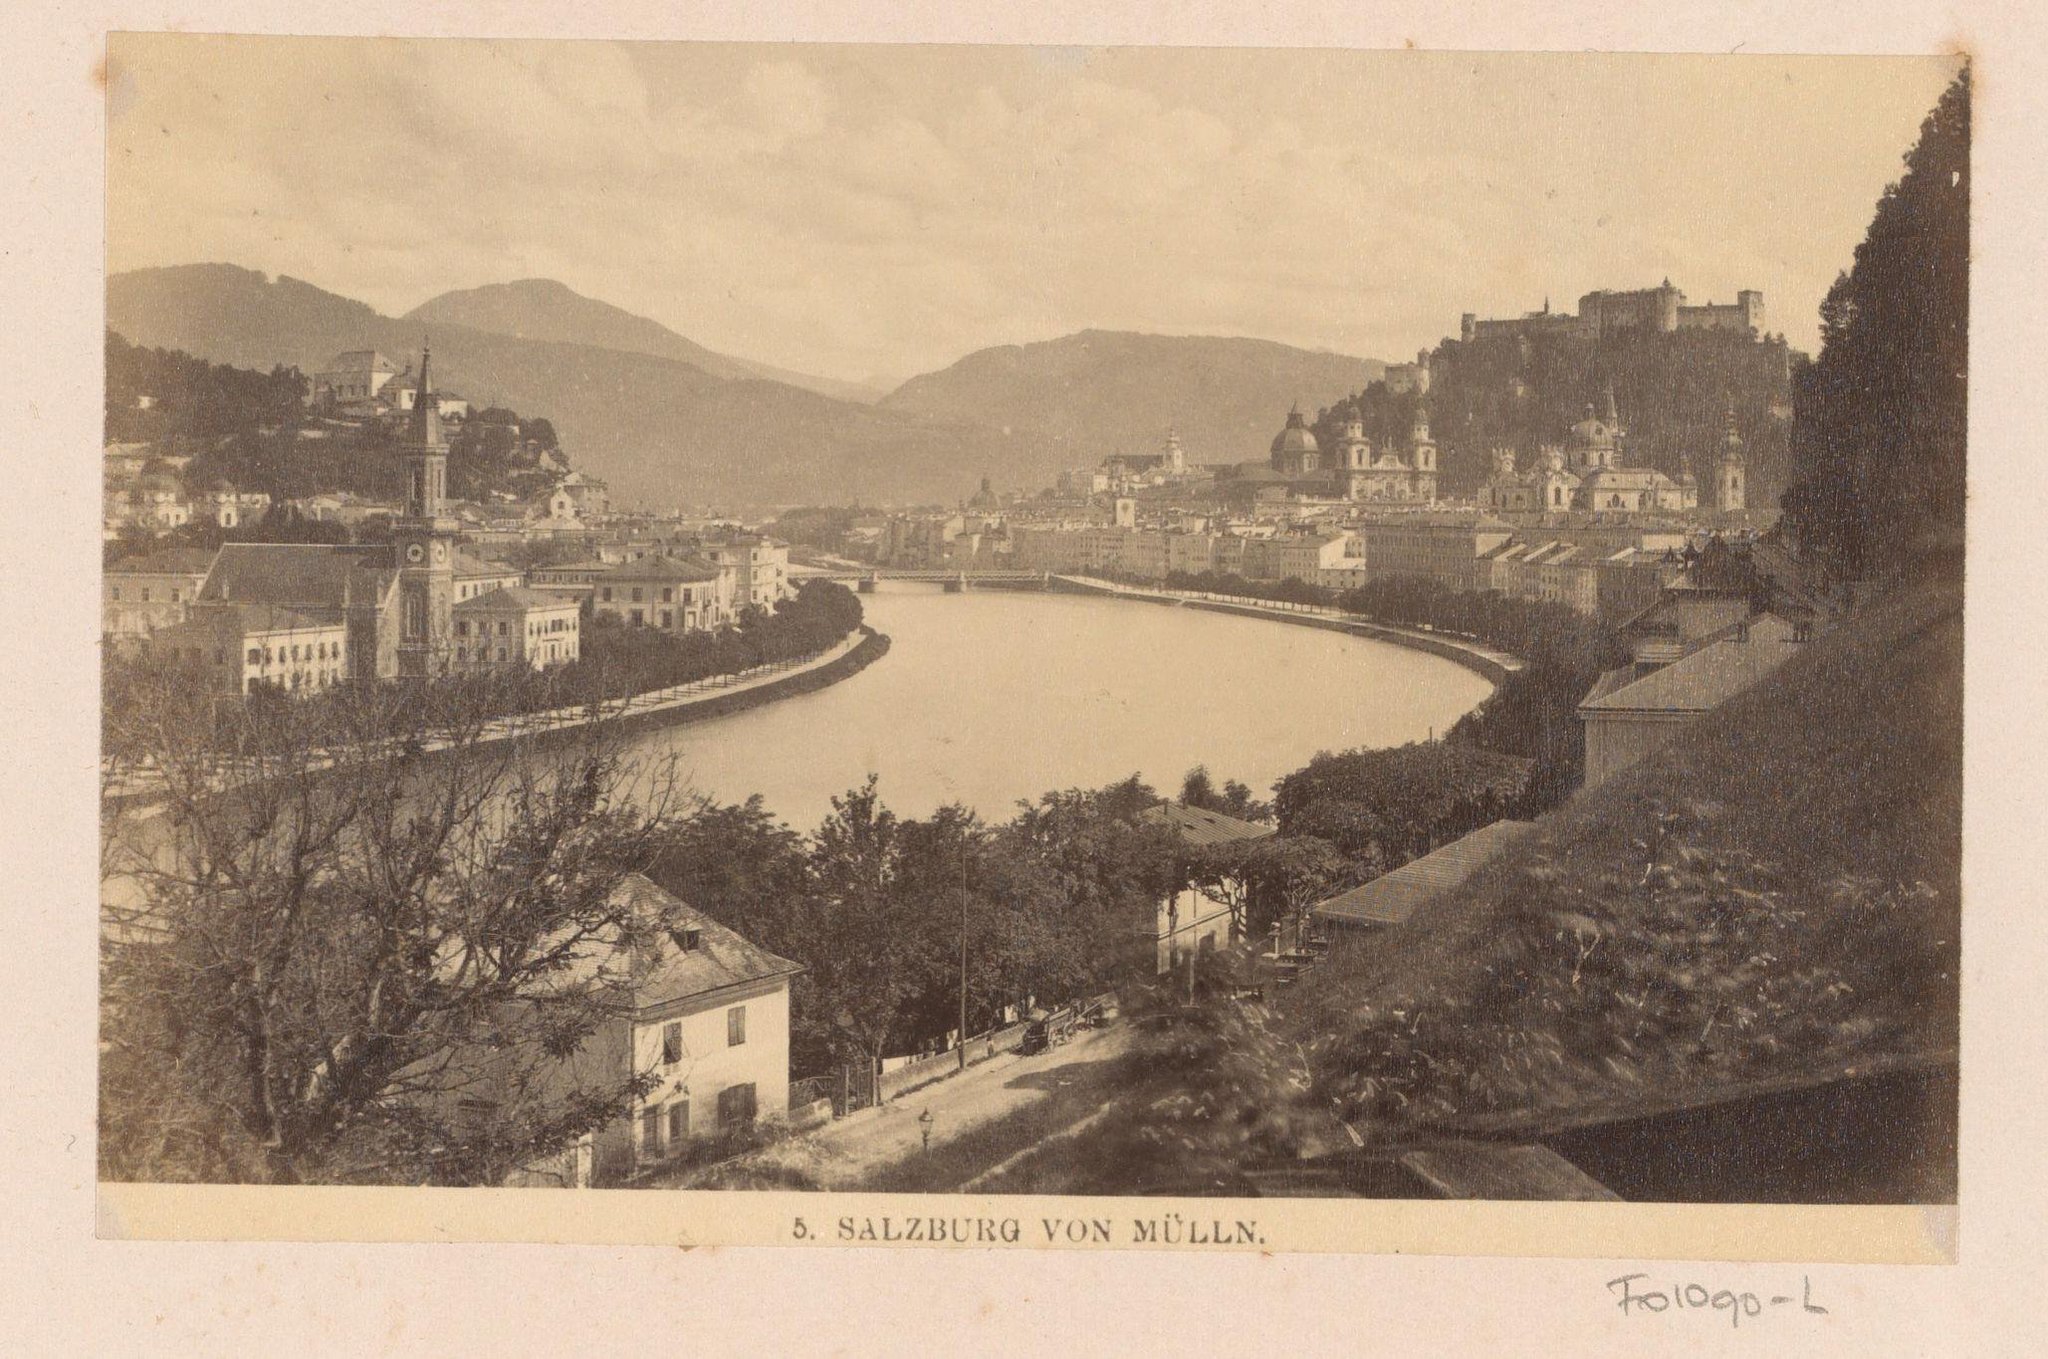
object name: photograph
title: Gezicht op Salzburg vanaf Mülln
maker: Anonymous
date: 1870-1900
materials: paper, photographic support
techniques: albumen print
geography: drievuldigheidskerk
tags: river (+ landscape with figures, staffage), prospect of city, town panorama, silhouette of city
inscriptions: negative number: ‘5’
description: Onderdeel van Reisalbum met foto's van bezienswaardigheden in Duitsland en Oostenrijk en van kunstwerken.